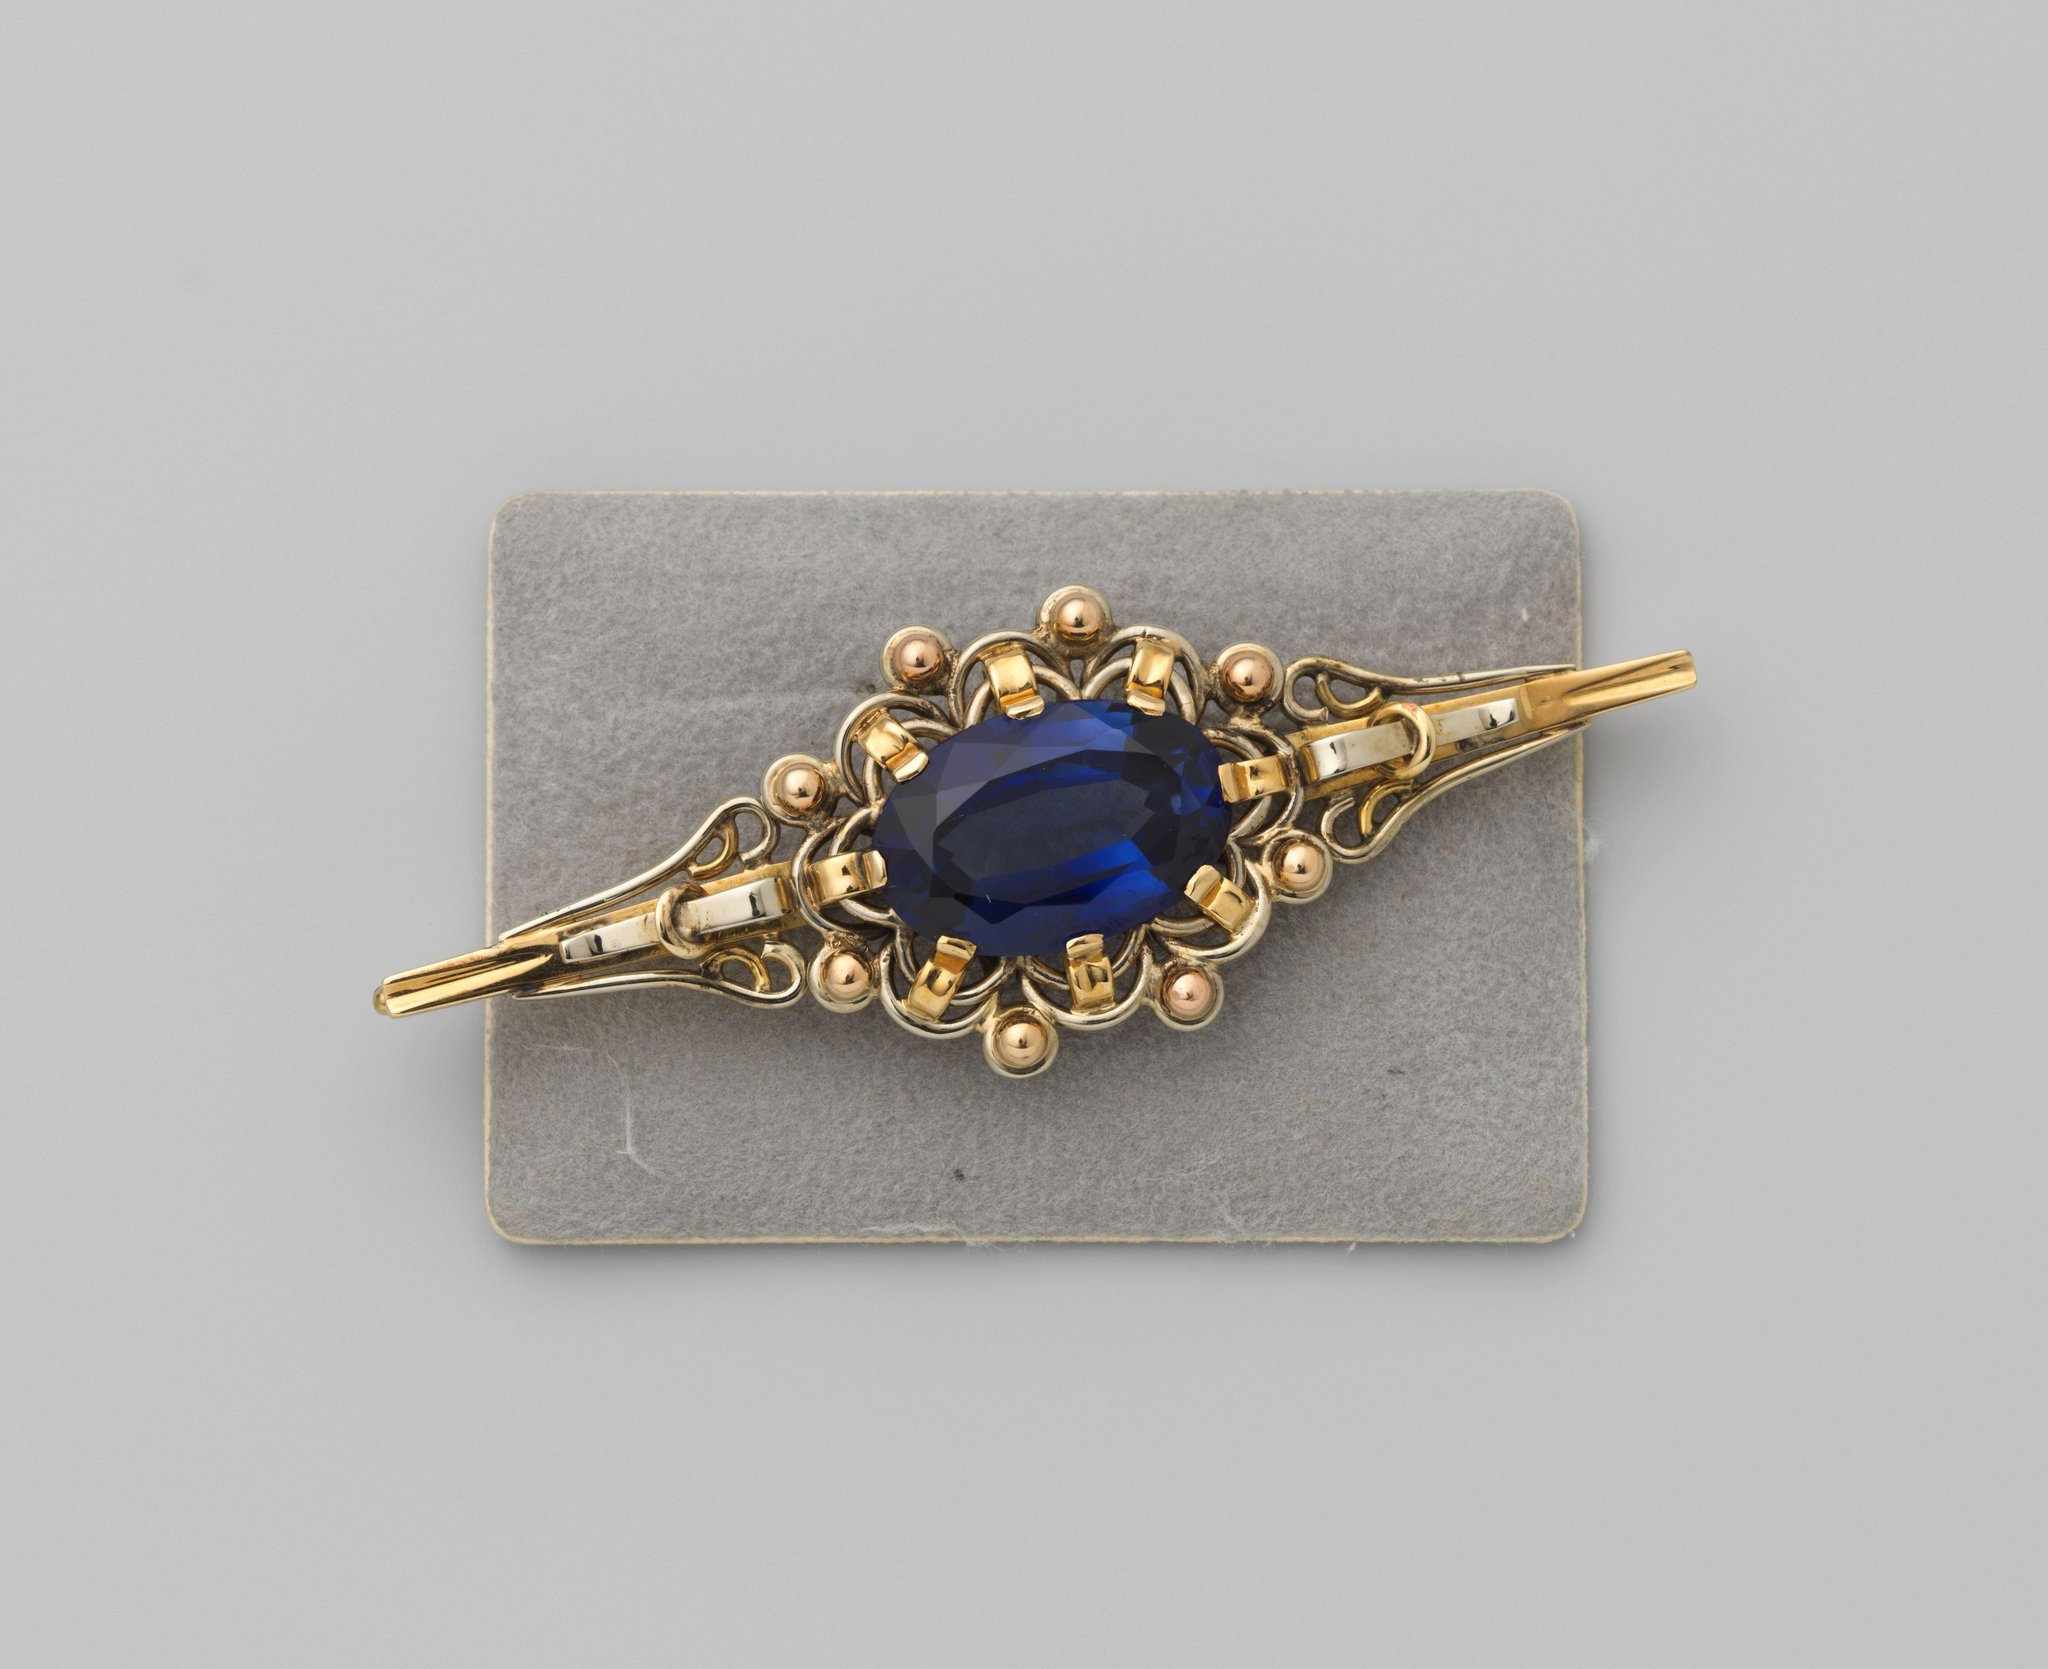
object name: brooch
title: Brochette van goud met een ovaal blauw glas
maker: Anonymous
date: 1946-1954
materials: glass, gold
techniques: faceting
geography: utrecht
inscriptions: maker's mark: ‘AJC1’, alloy mark: ‘(oud) eikenblad’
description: Brochette van tweekleurig goud met ovaal blauw gefacetteerd glas voorzien van een kanonsluiting. De bolletjes zijn van rood goud.